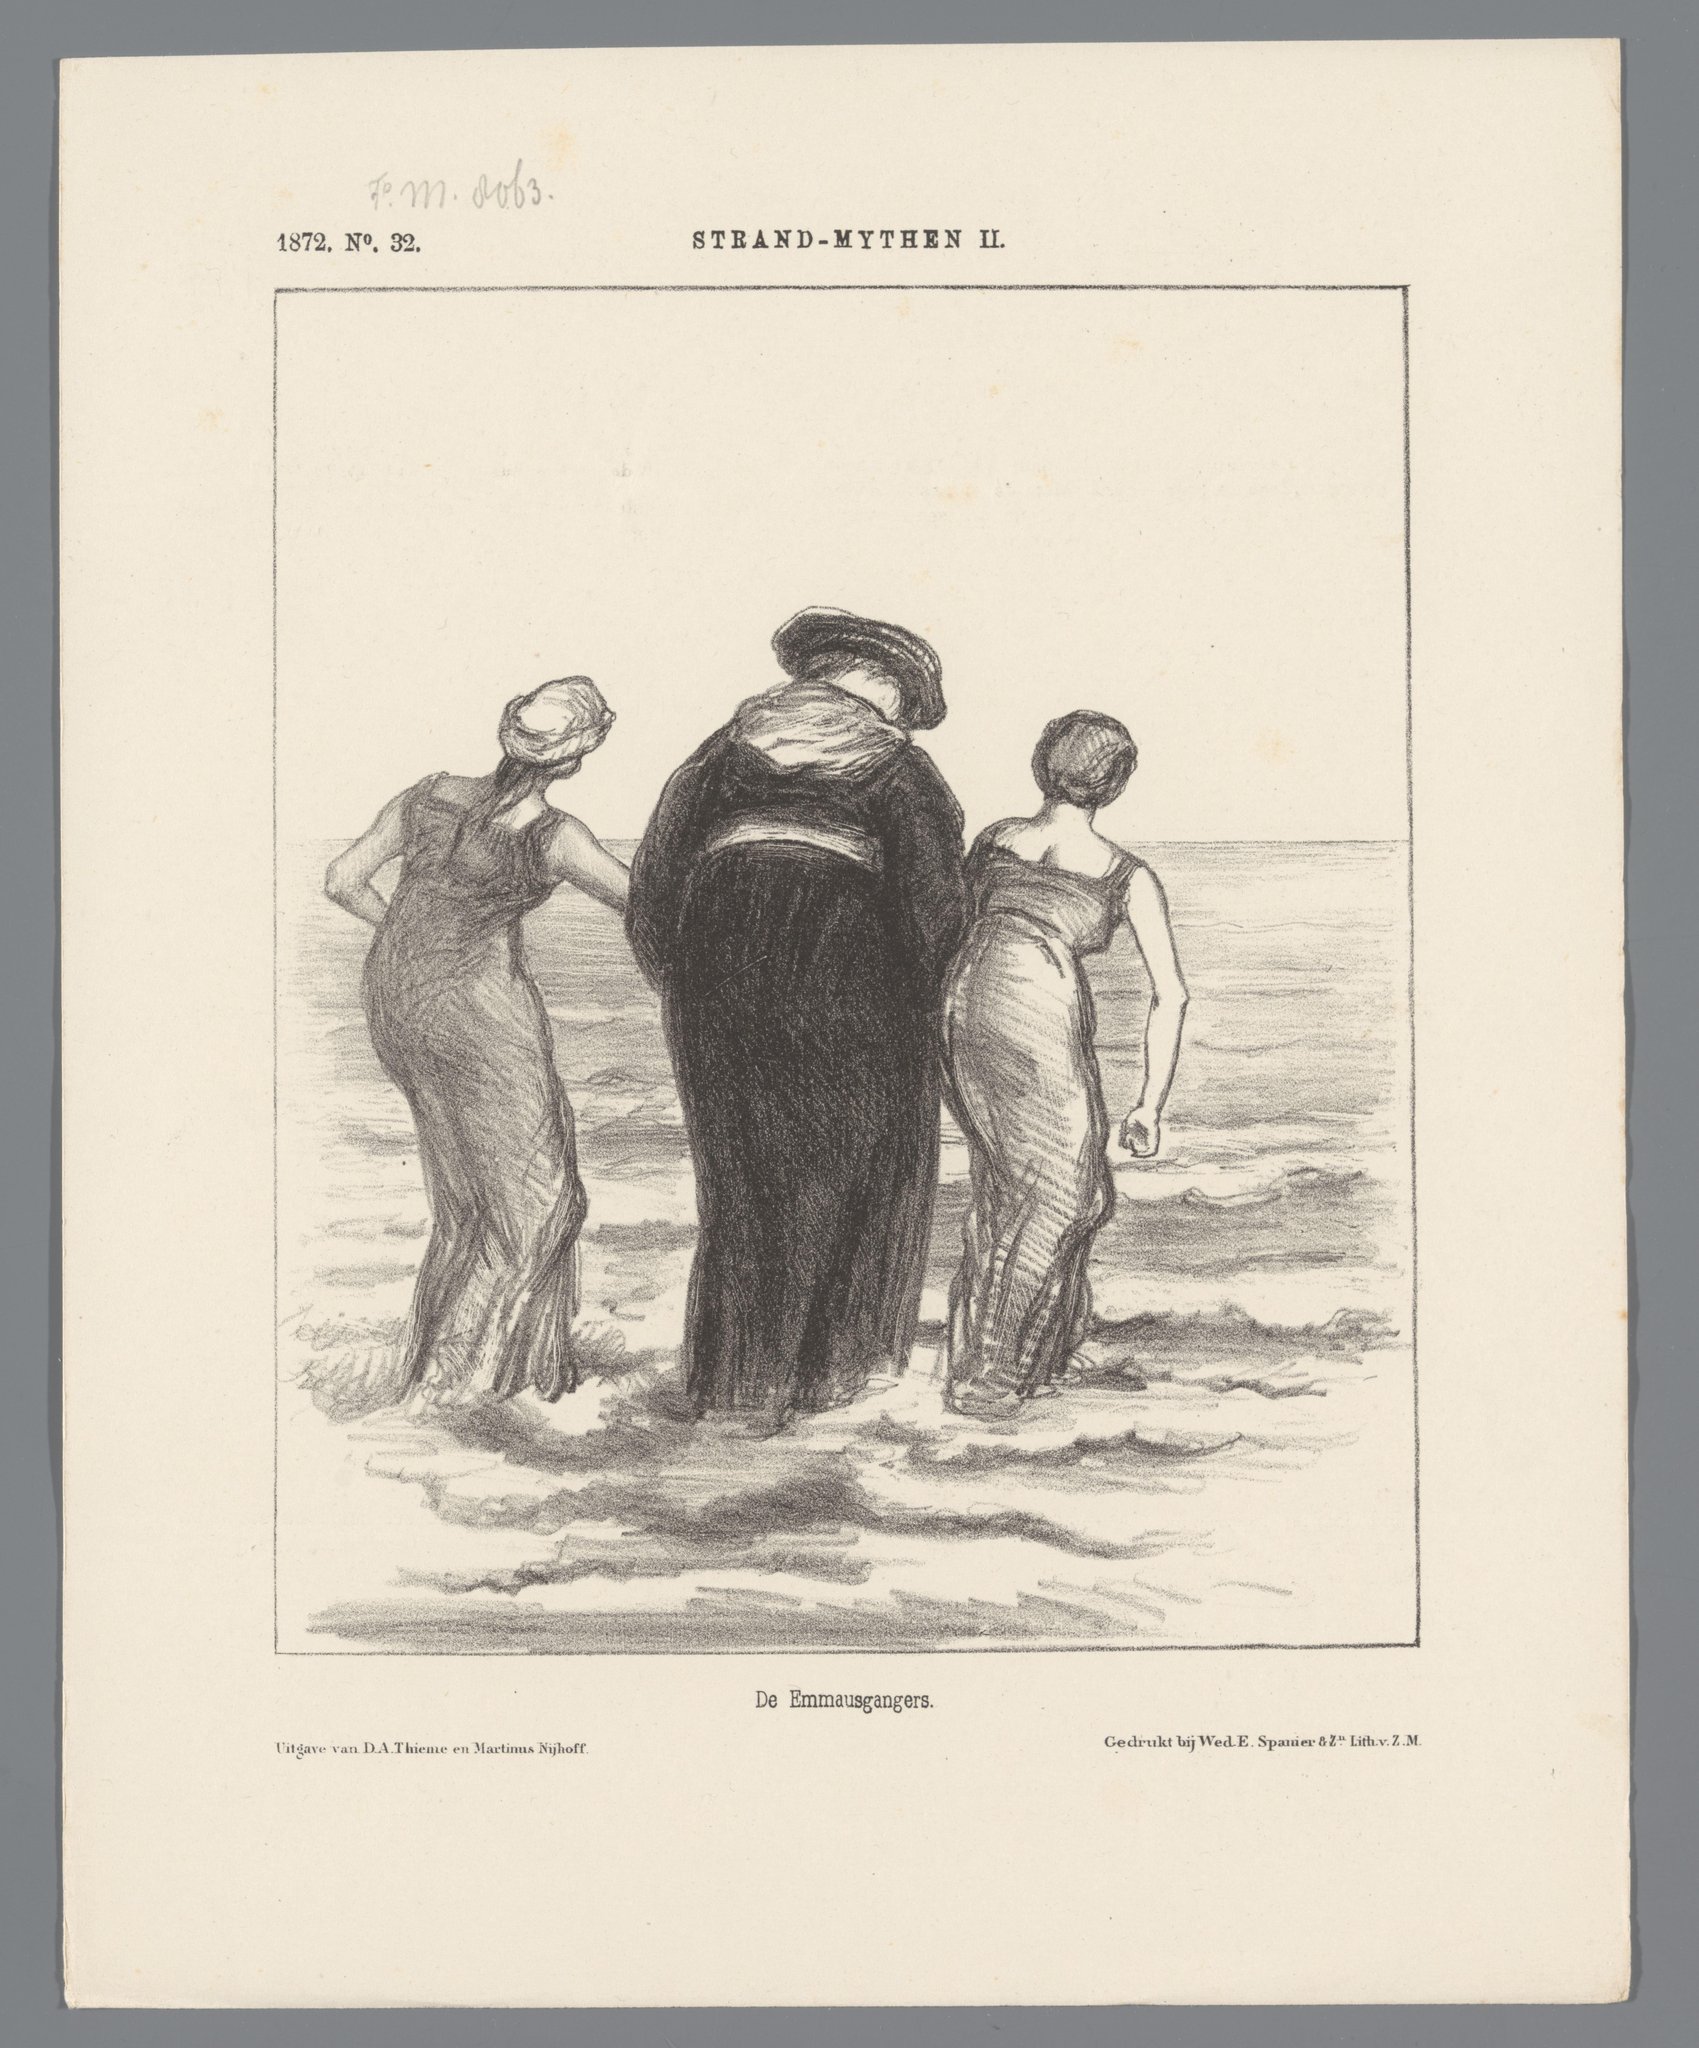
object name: cartoon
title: Spotprent met een forse Scheveningse vrouw begeleid door twee jonge vrouwen, 1872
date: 1872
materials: paper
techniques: lithograph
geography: the hague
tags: in or beside the water (on the beach)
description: Spotprent waarin een forse Scheveningse vrouw begeleid door twee jonge vrouwen de zee in gaat. Plaat verschenen bij het weekblad De Nederlandsche Spectator, nr. 32, 1872.